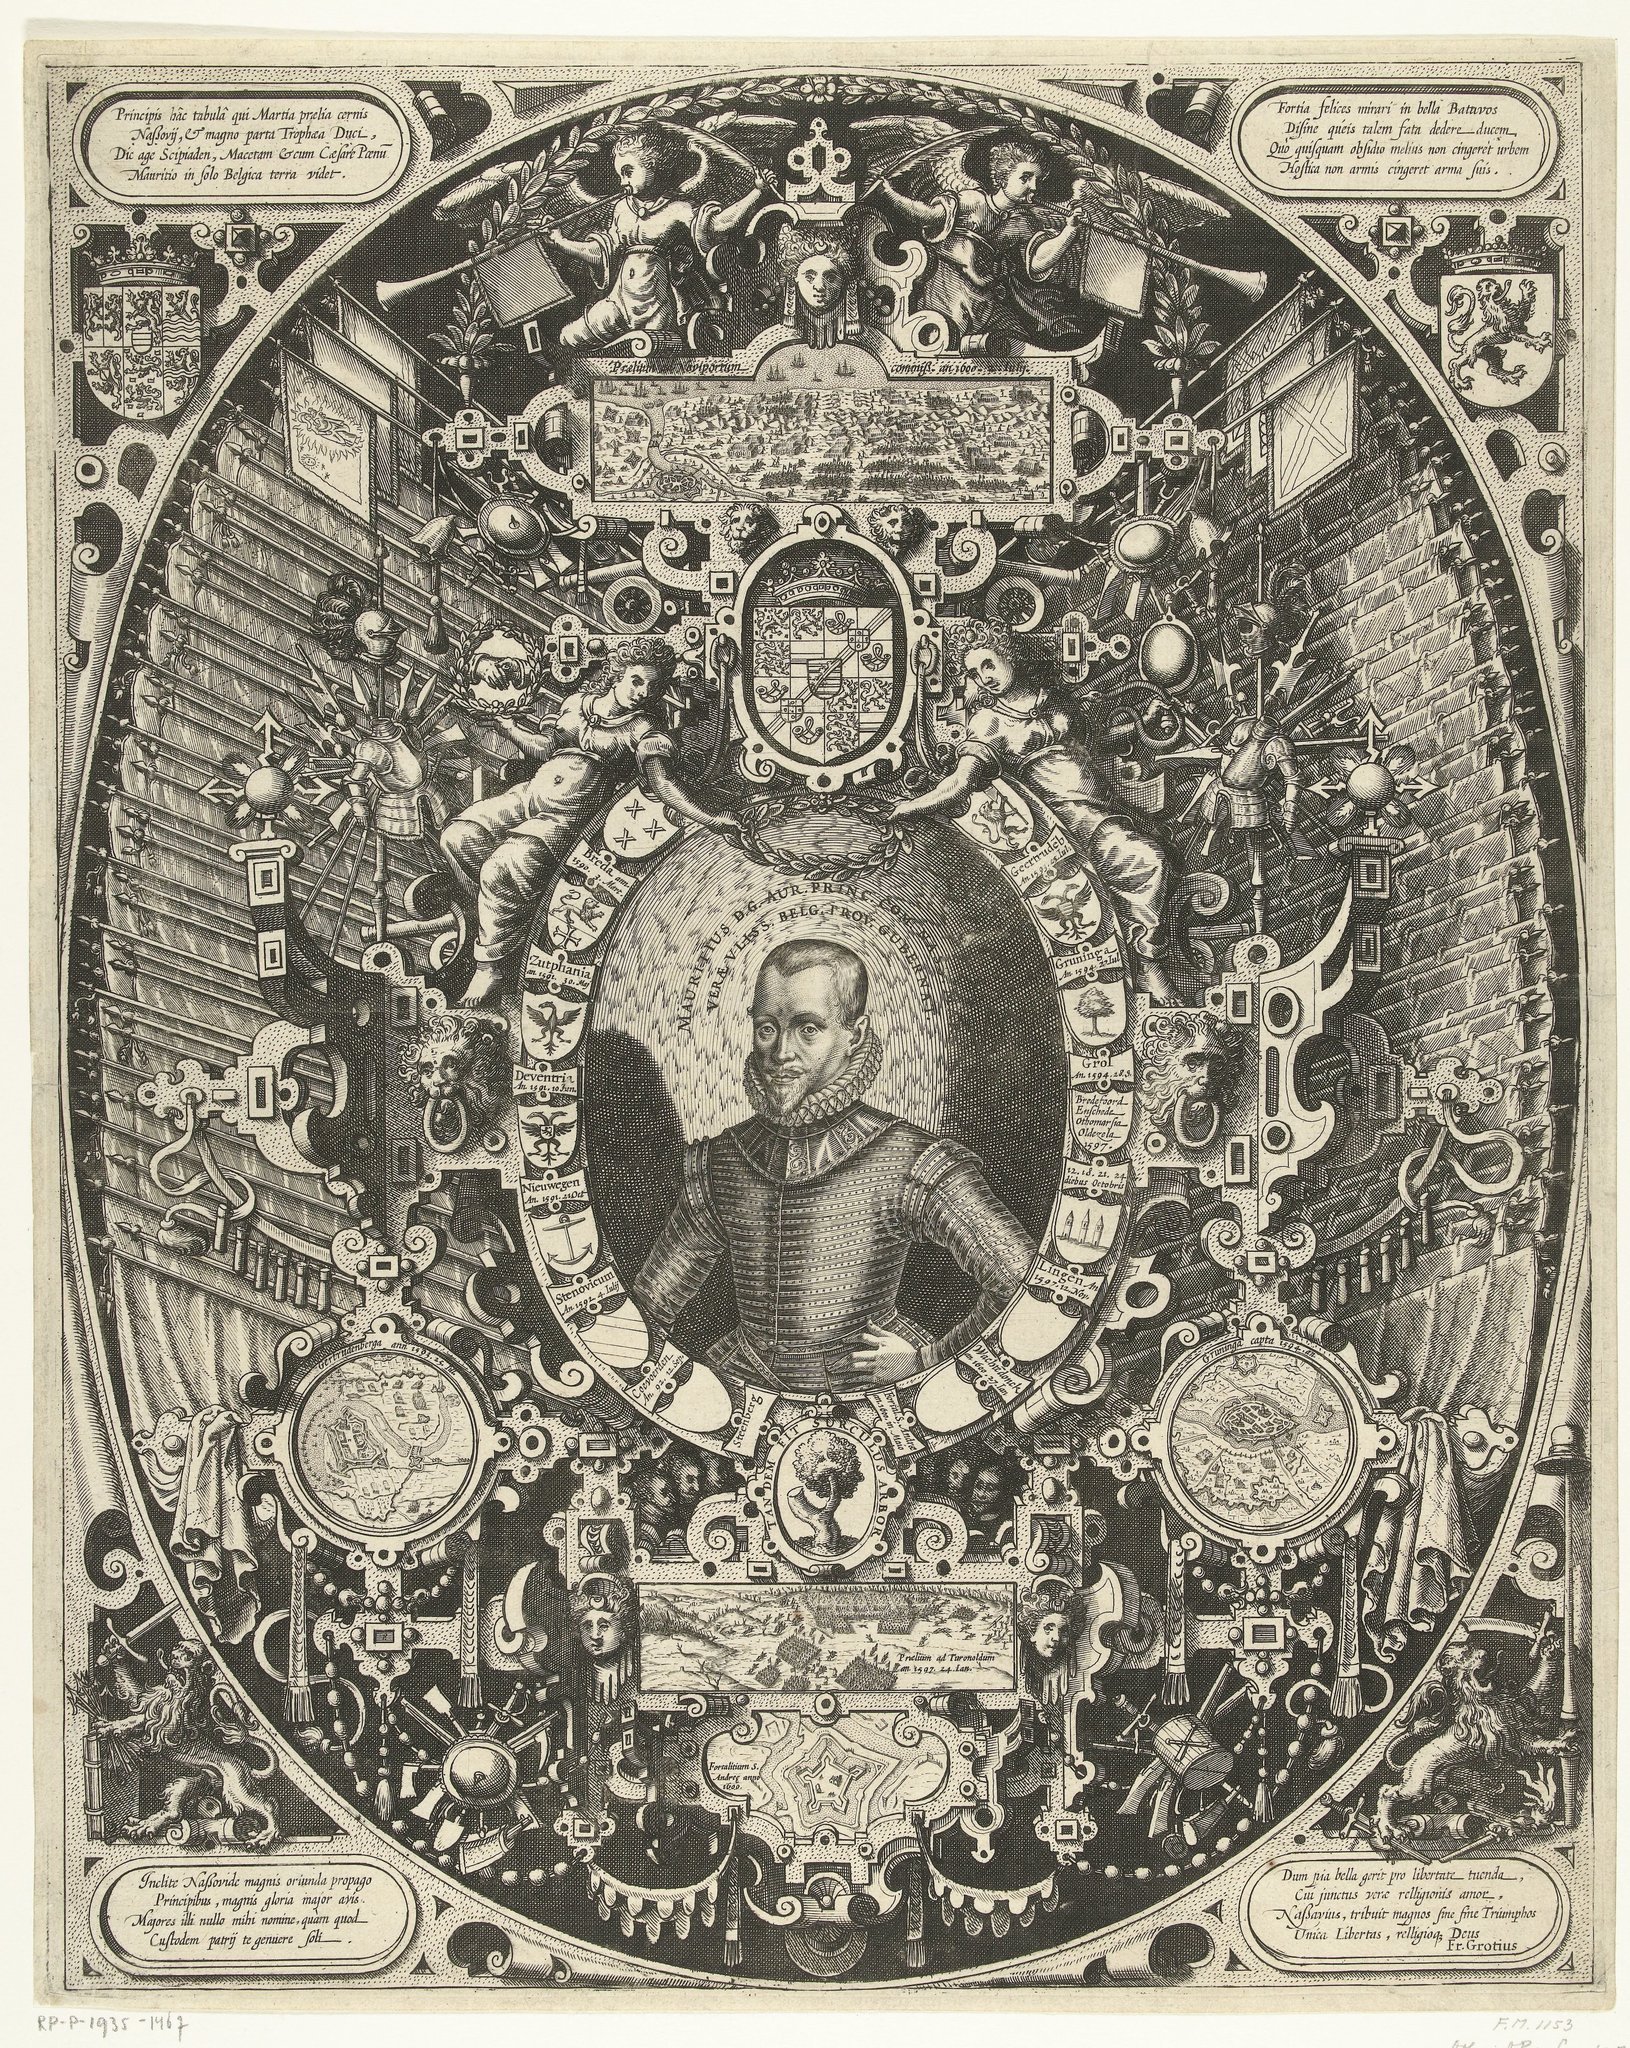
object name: propagandaprent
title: Allegorisch portret van prins Maurits, 1600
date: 1600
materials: paper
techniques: engraving, etching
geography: northern netherlands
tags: the hague, maurice (prince of orange), prudence, 'prudentia'; 'prudenza' (ripa) ~ one of the four cardinal virtues, agreement, unity; 'concordia', 'concordia insuperabile', 'concordia militare', 'concordia di pace', 'unione civile' (ripa) (+ abstract concept represented by female figure), battle of nieuwpoort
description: Allegorisch portret van prins Maurits. Grote ovale propagandaprent over de overwinningen van prins Maurits in de jaren 1593-1600, culminerend in de slag bij Nieuwpoort, 2 juli 1600. In het midden een portret van de prins omringd met een keten gevormd door de wapens van de veroverde plaatsen. Eendracht en Voorzichtigheid houden een lauwerkrans boven zijn hoofd. In vijf kleine scènes de veroveringen te Geertruidenberg (1593), Groningen (1594), Turnhout (1597), Sint-Andries (1600) en Nieuwpoort (1600). Verder rolwerk, wapentrofeeën en de buitgemaakte Spaanse vaandels. In de 4 hoeken versjes van 4 regels in het Latijn. Onderaan links en rechts de Hollandse leeuw met (links) de pijlenbundel en (rechts) zwaard, lans met vrijheidshoed. Verder ook de wapens van de prins en van de Staten-Generaal.